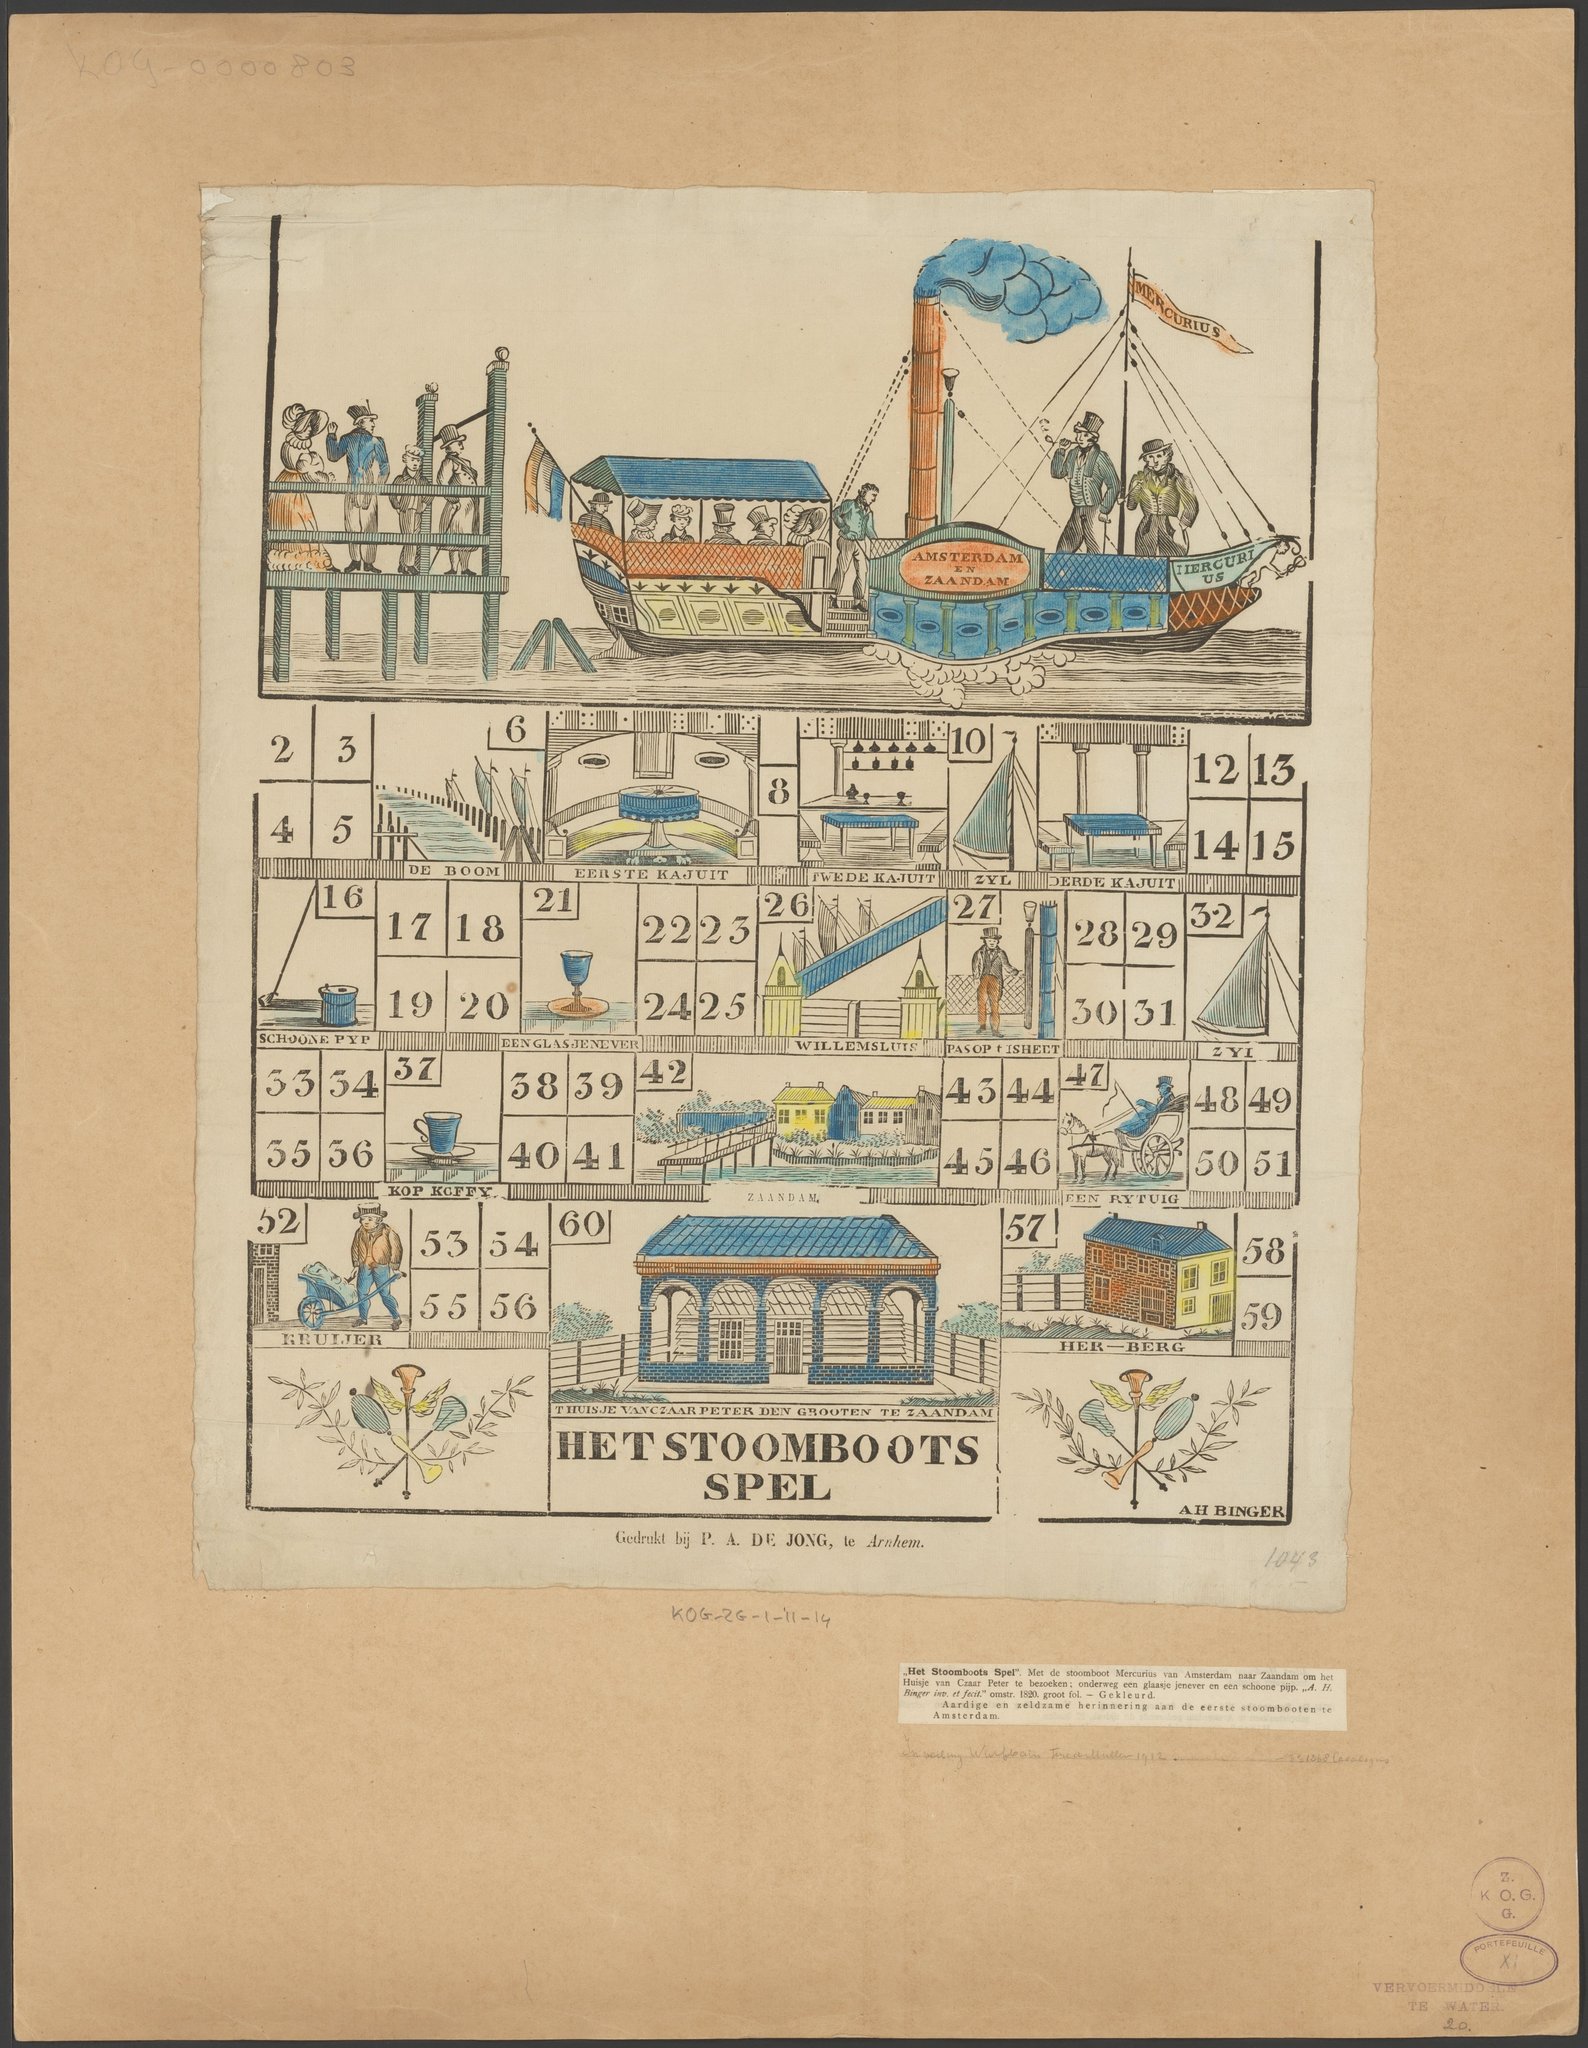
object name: print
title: Het stoomboots spel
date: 1850-1860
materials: paper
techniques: hand coloring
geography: arnhem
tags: migrants, hotel, hostelry, inn, steamship, motorship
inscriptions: stamp, stamp, collector's mark: Lugt 1641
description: Bordspel met vakjes genummerd van 2 tot en met 60. Boven een voorstelling van een stoomboot genaamd Mercurius. De boot vaart op en neer tussen Amsterdam en Zaandam. In verschillende vakjes afbeeldingen van voorwerpen, gebouwen en figuren. Midden onder de titel. Onderwerpsrubrieken binnen de Atlas Zeden en Gewoonten: Handel, nijverheid en verkeer, Vervoermiddelen te land en te water, Vervoermiddelen te water.